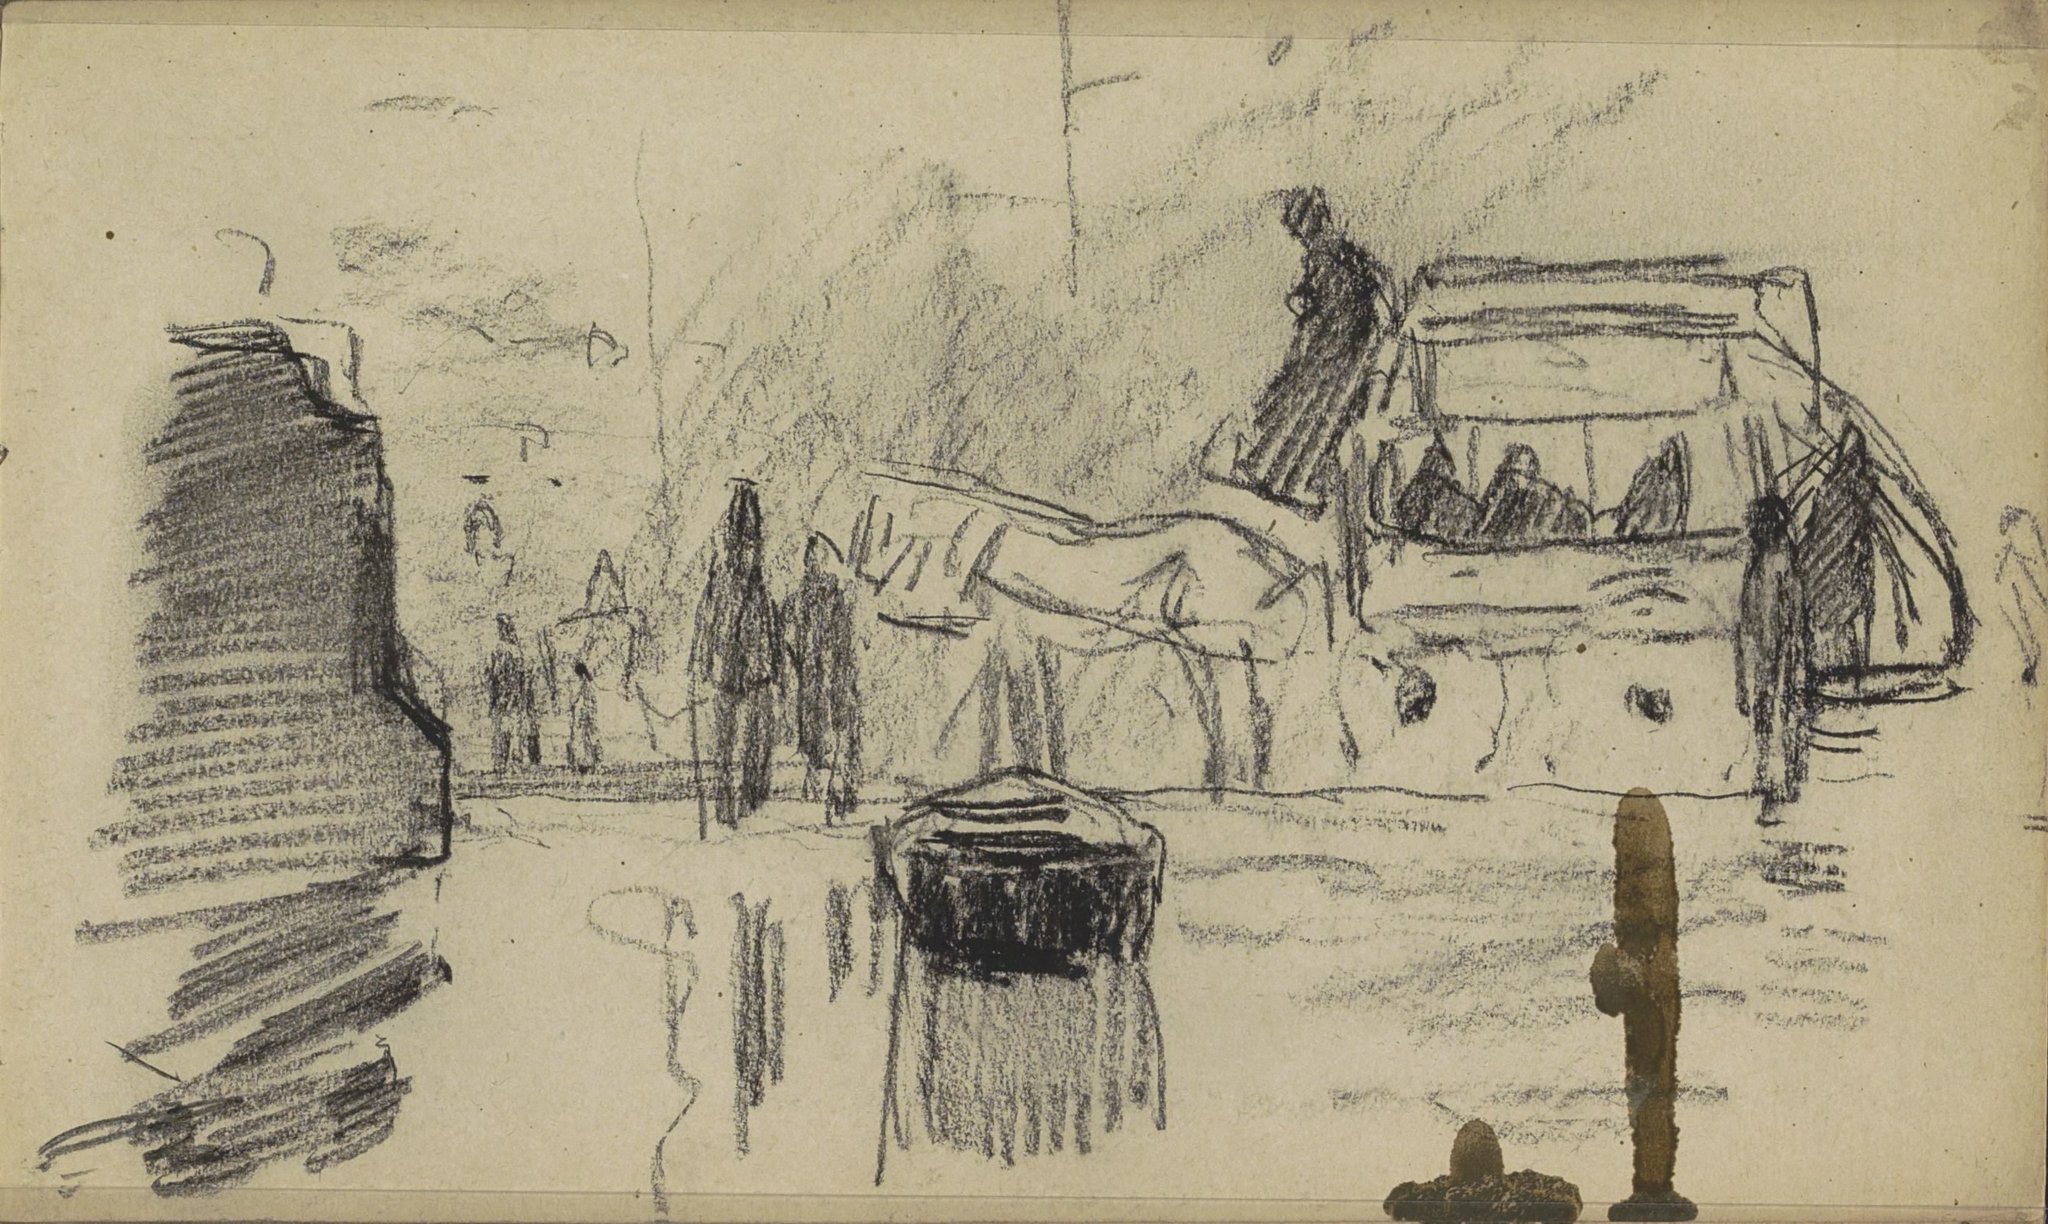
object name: sketchbook leaf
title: Stadsgezicht met een paard-en-wagen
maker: willem witsen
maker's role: draughtsman, painter, print maker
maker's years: 1860-1923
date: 1887-1897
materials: chalk, paper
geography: amsterdam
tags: city-view, and landscape with man-made constructions, four-wheeled, animal-drawn vehicle, e.g.: cab, carriage, coach, amsterdam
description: Pagina 47 uit een schetsboek met 25 bladen.